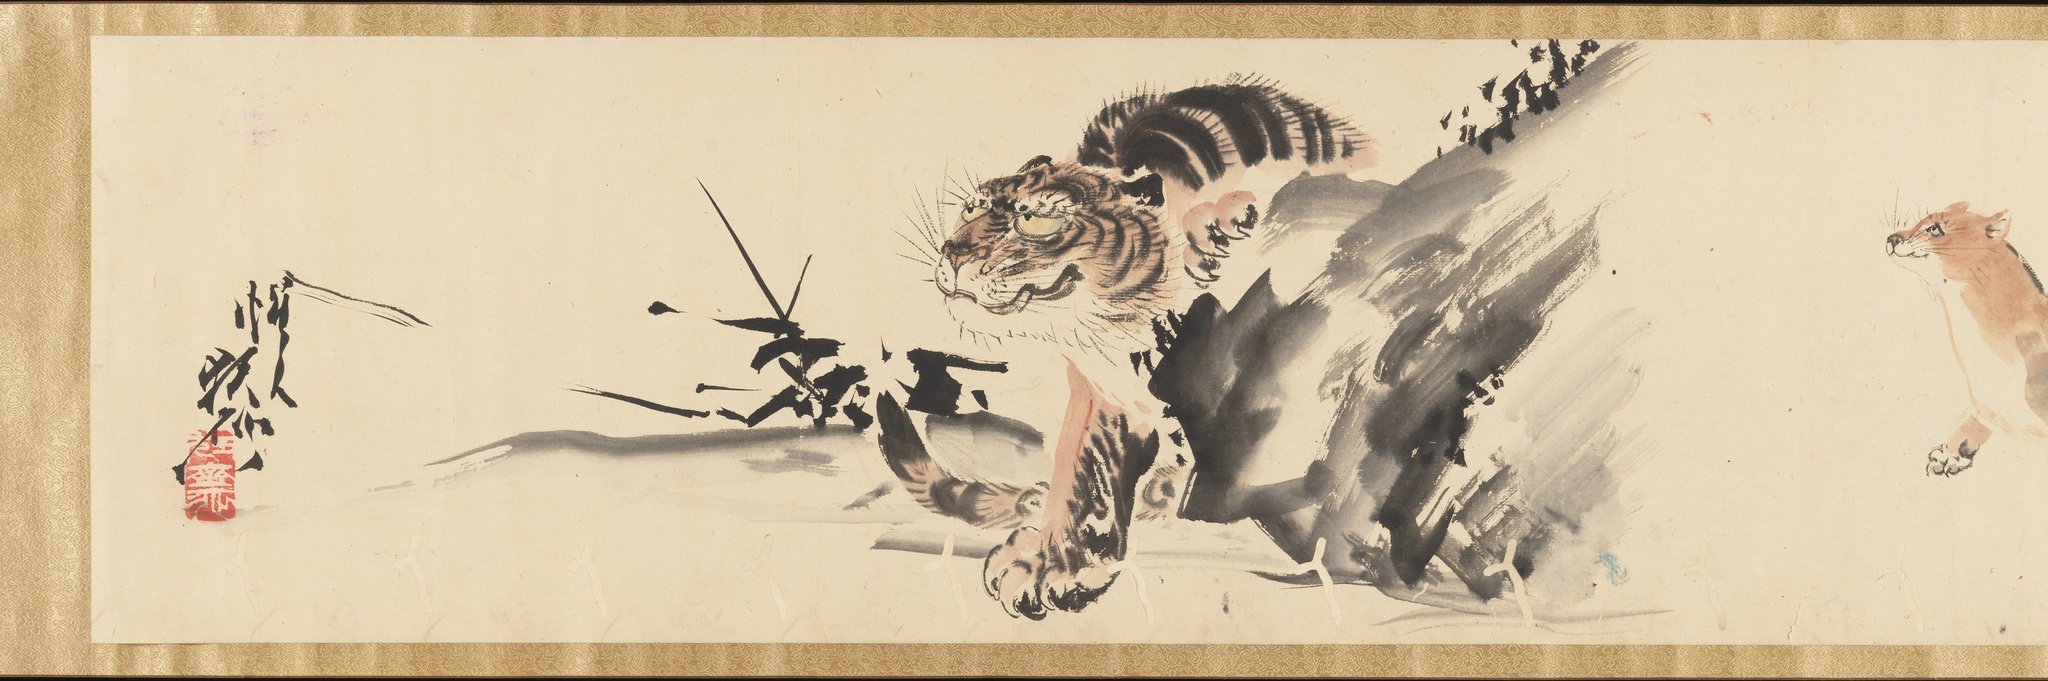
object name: handscroll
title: Sketches of Birds and Animals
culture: japanese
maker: kawanabe kyōsai 河鍋暁斎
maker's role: artist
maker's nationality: japanese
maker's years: 1831-1889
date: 1867-1900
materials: ink, paper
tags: birds,deer,foxes,tigers